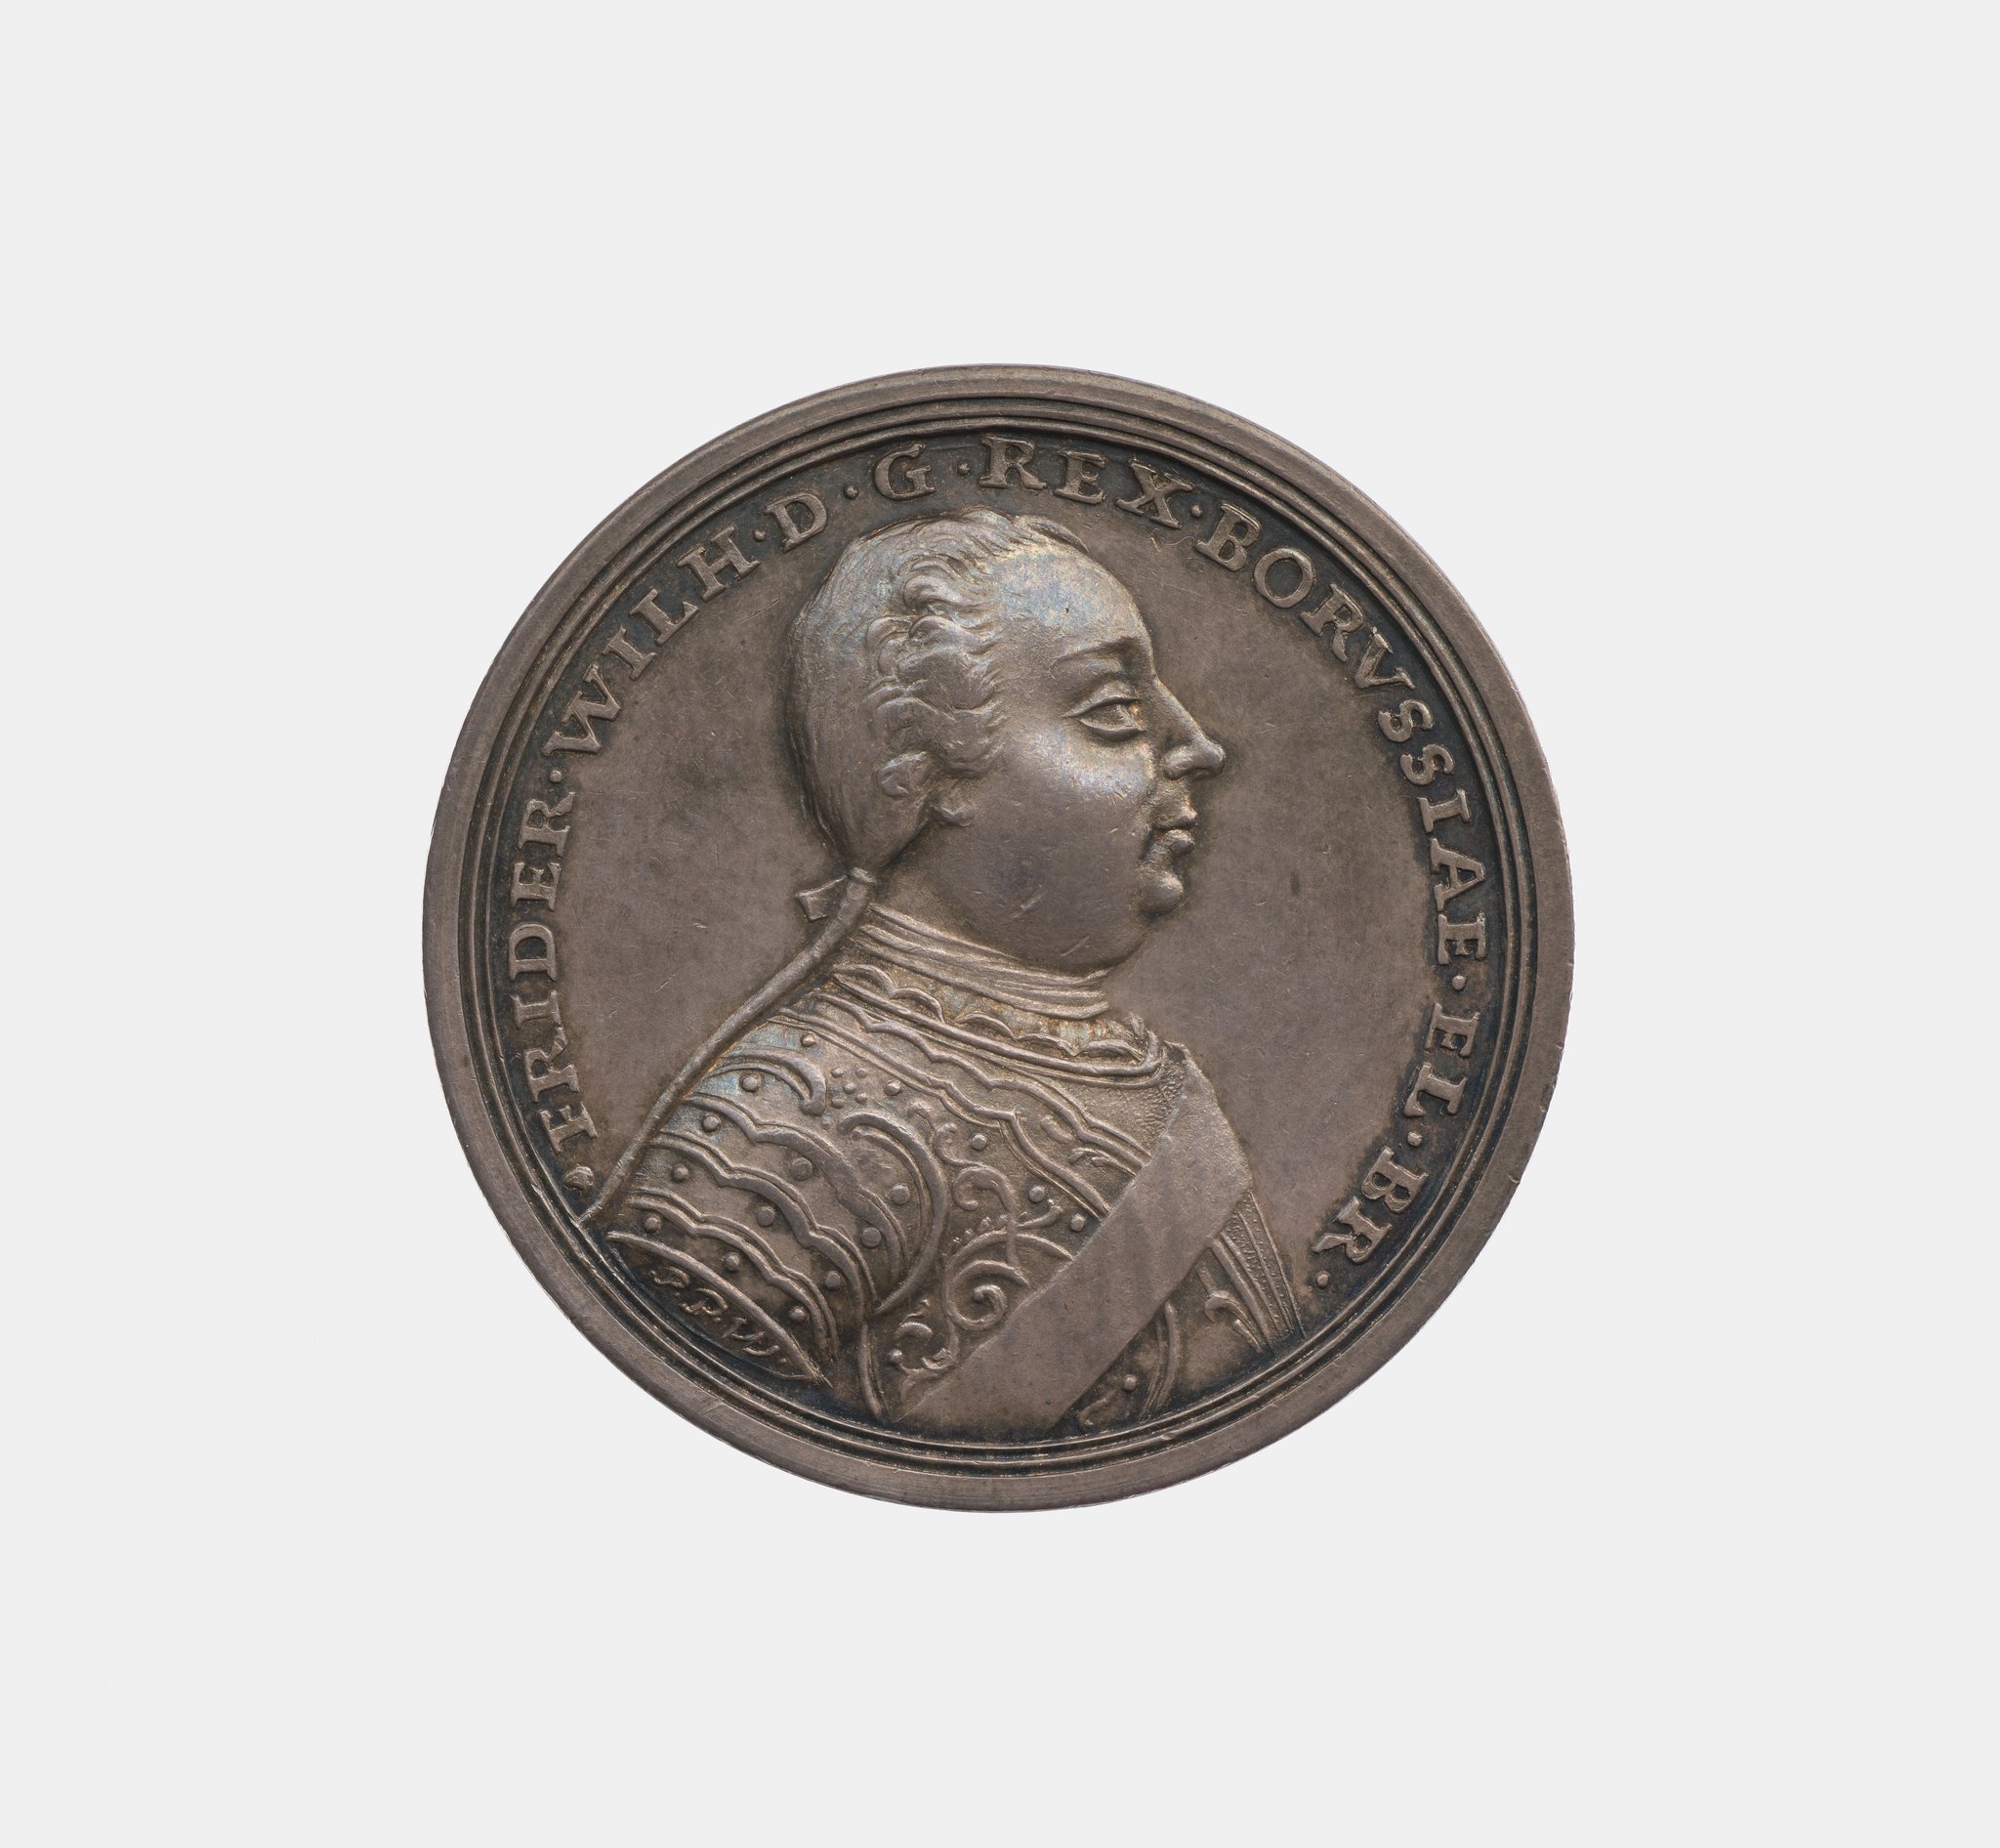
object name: medal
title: Frederich Wilhelm I / Arrival of the Salzurg emigrants in Prussia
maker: peter paul werner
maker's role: medailleur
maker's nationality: german, nuremberg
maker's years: 1689-1771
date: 1732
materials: silver